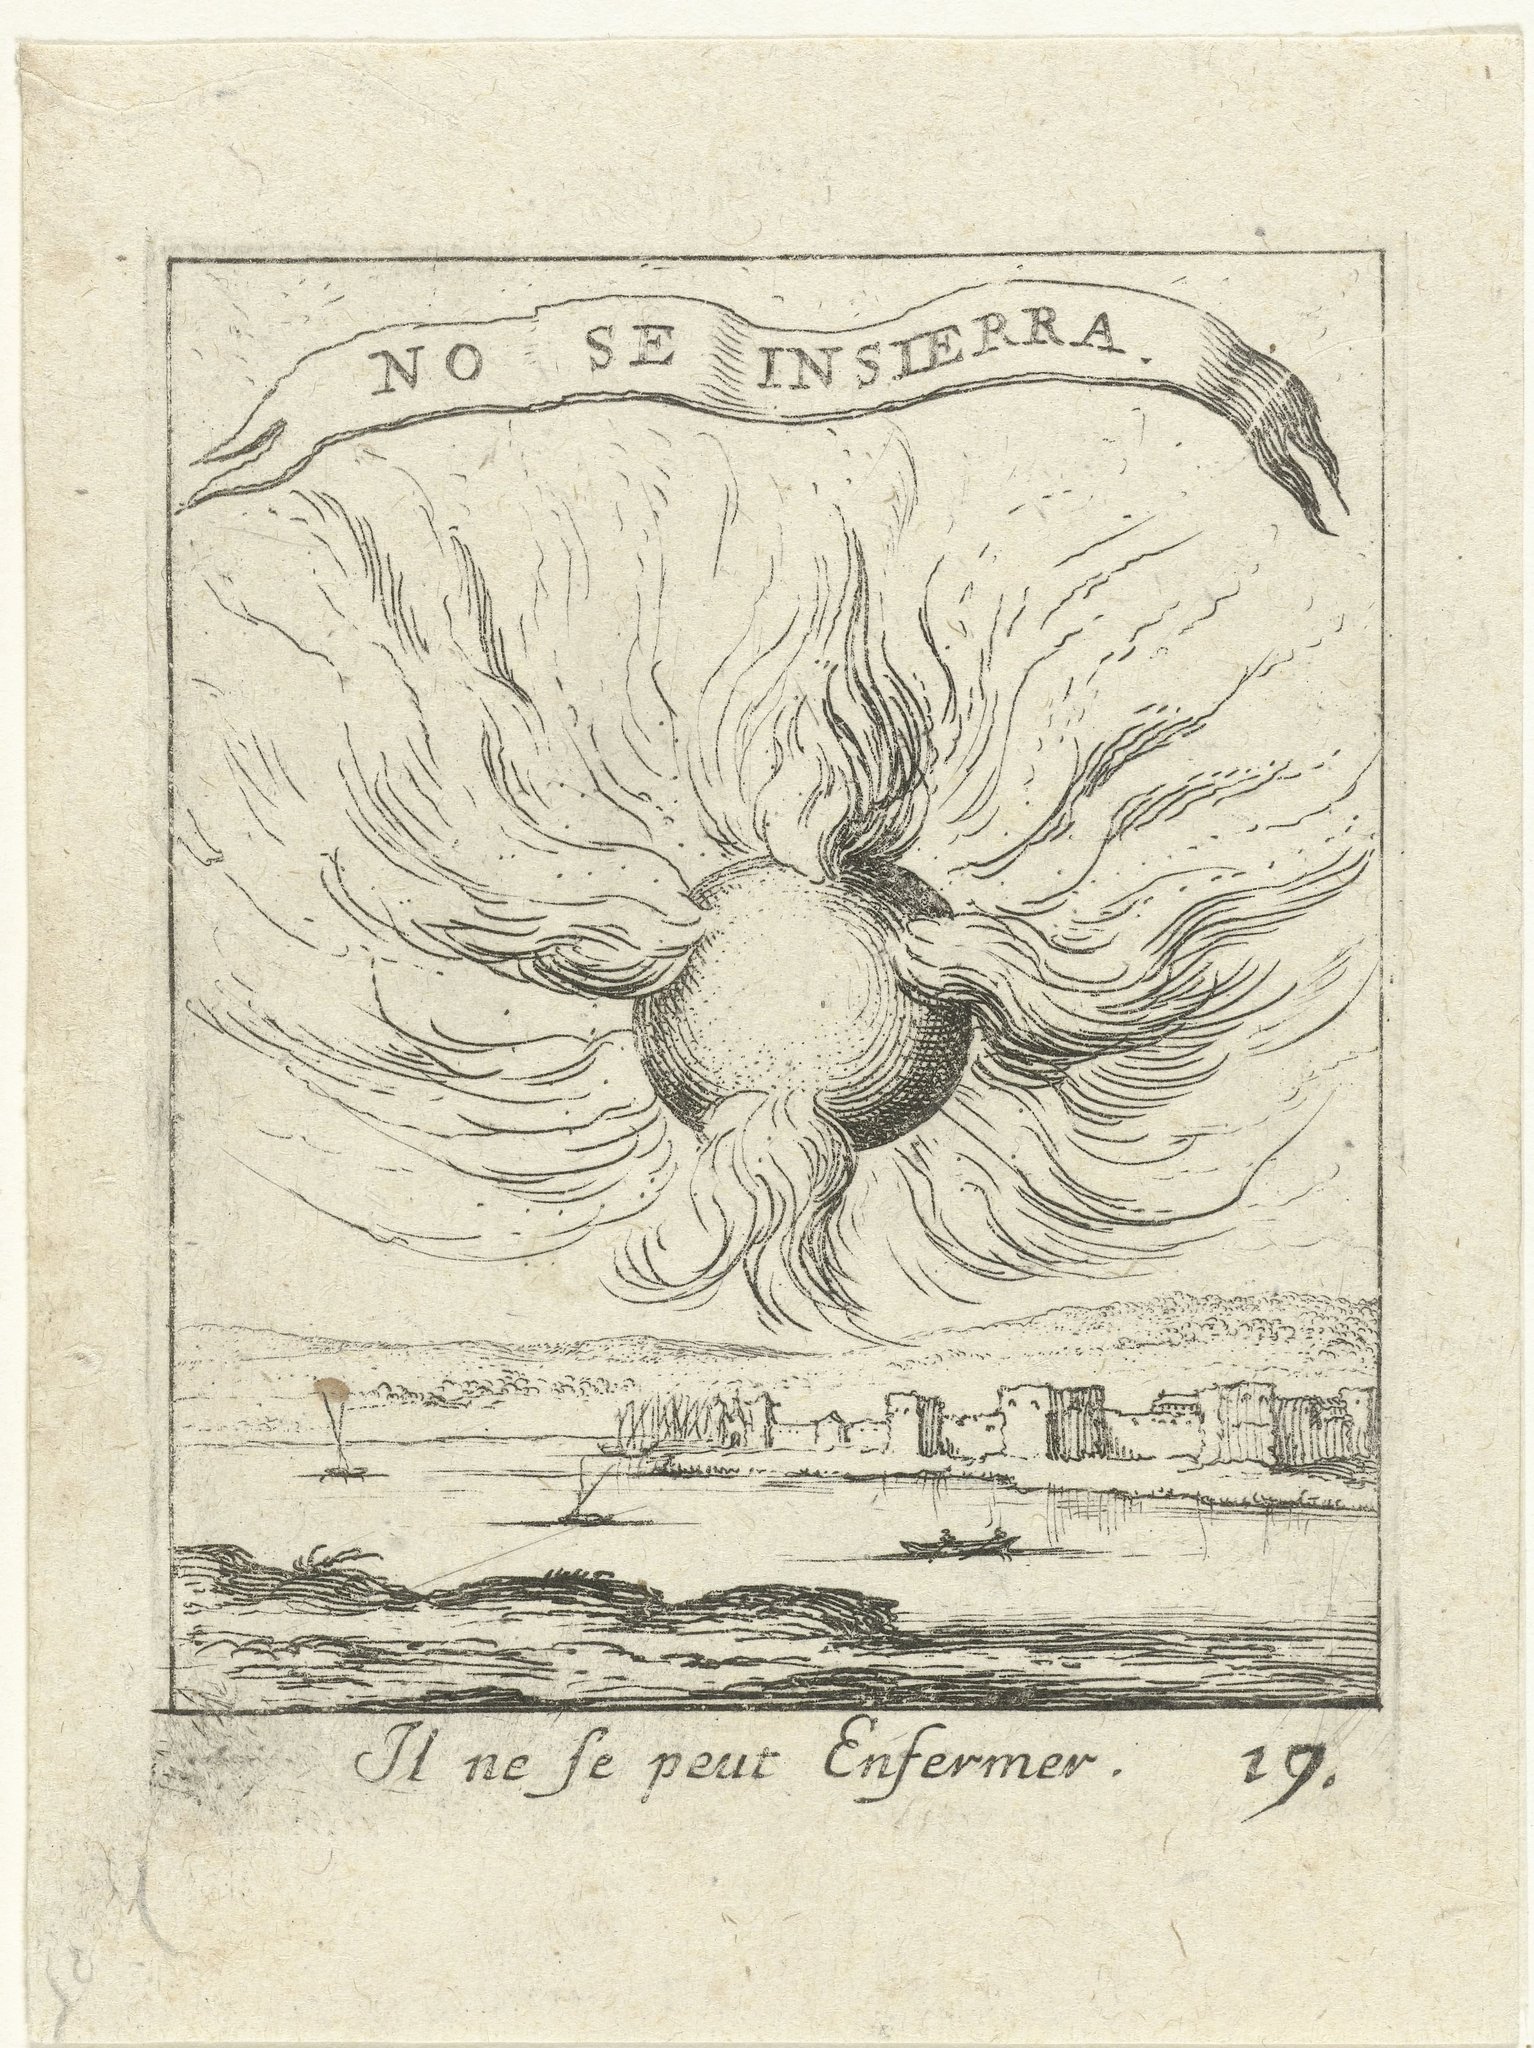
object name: print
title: Moraliserende liefdesemblemen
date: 1672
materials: paper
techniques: etching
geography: paris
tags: qualities of love: first series (+ emblematical representation of concept)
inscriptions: collector's mark: Lugt 2166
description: Een vlammende bal boven een riverlandschap. Op een banderol een devies in Latijn en een onderschrift in Frans, beide over de liefde.